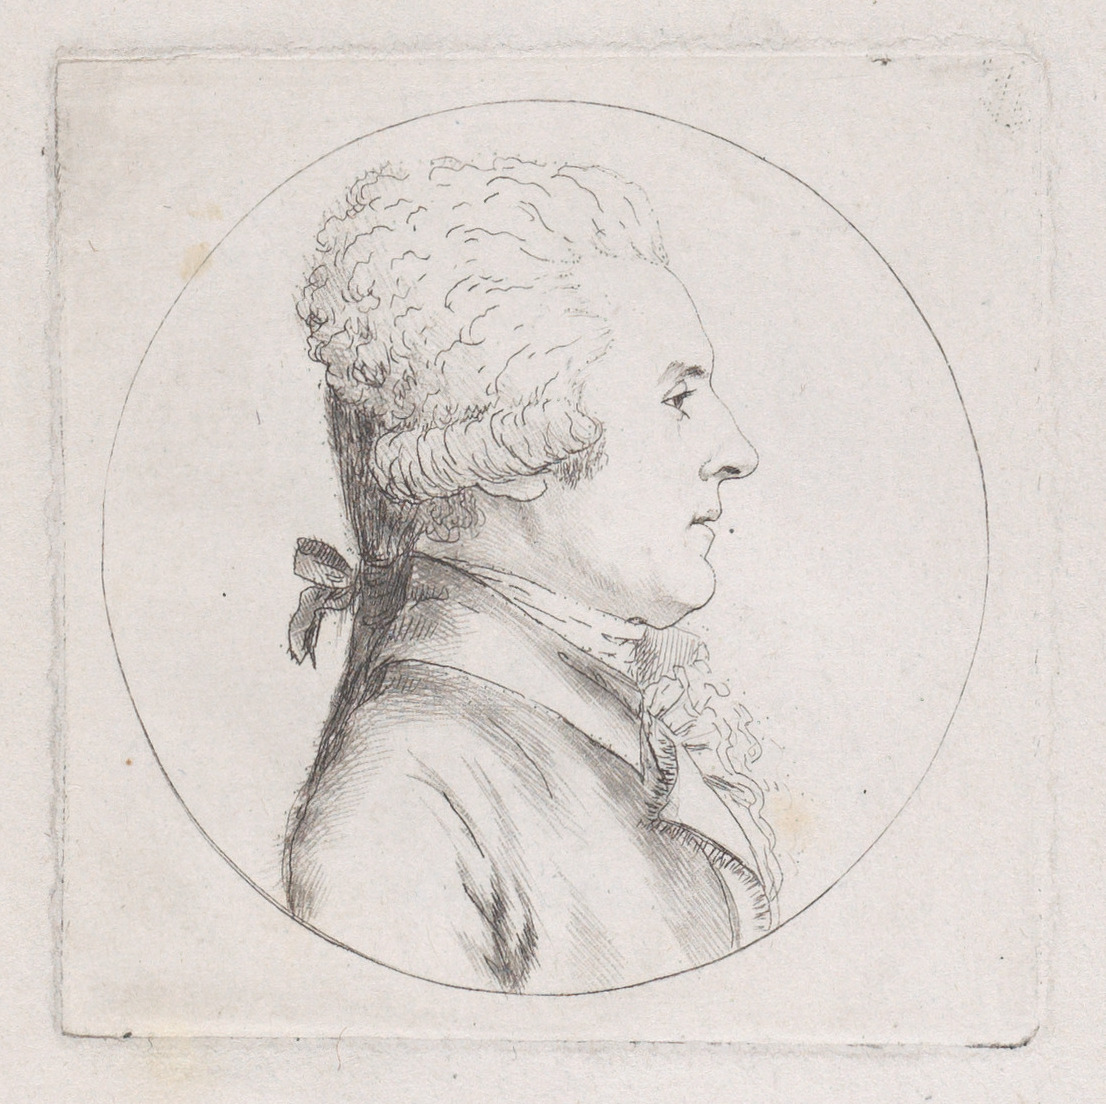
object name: print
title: Portrait of a man to right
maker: gilles louis chrétien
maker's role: artist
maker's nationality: french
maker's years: 1754-1811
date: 1786-1811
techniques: aquatint, etching